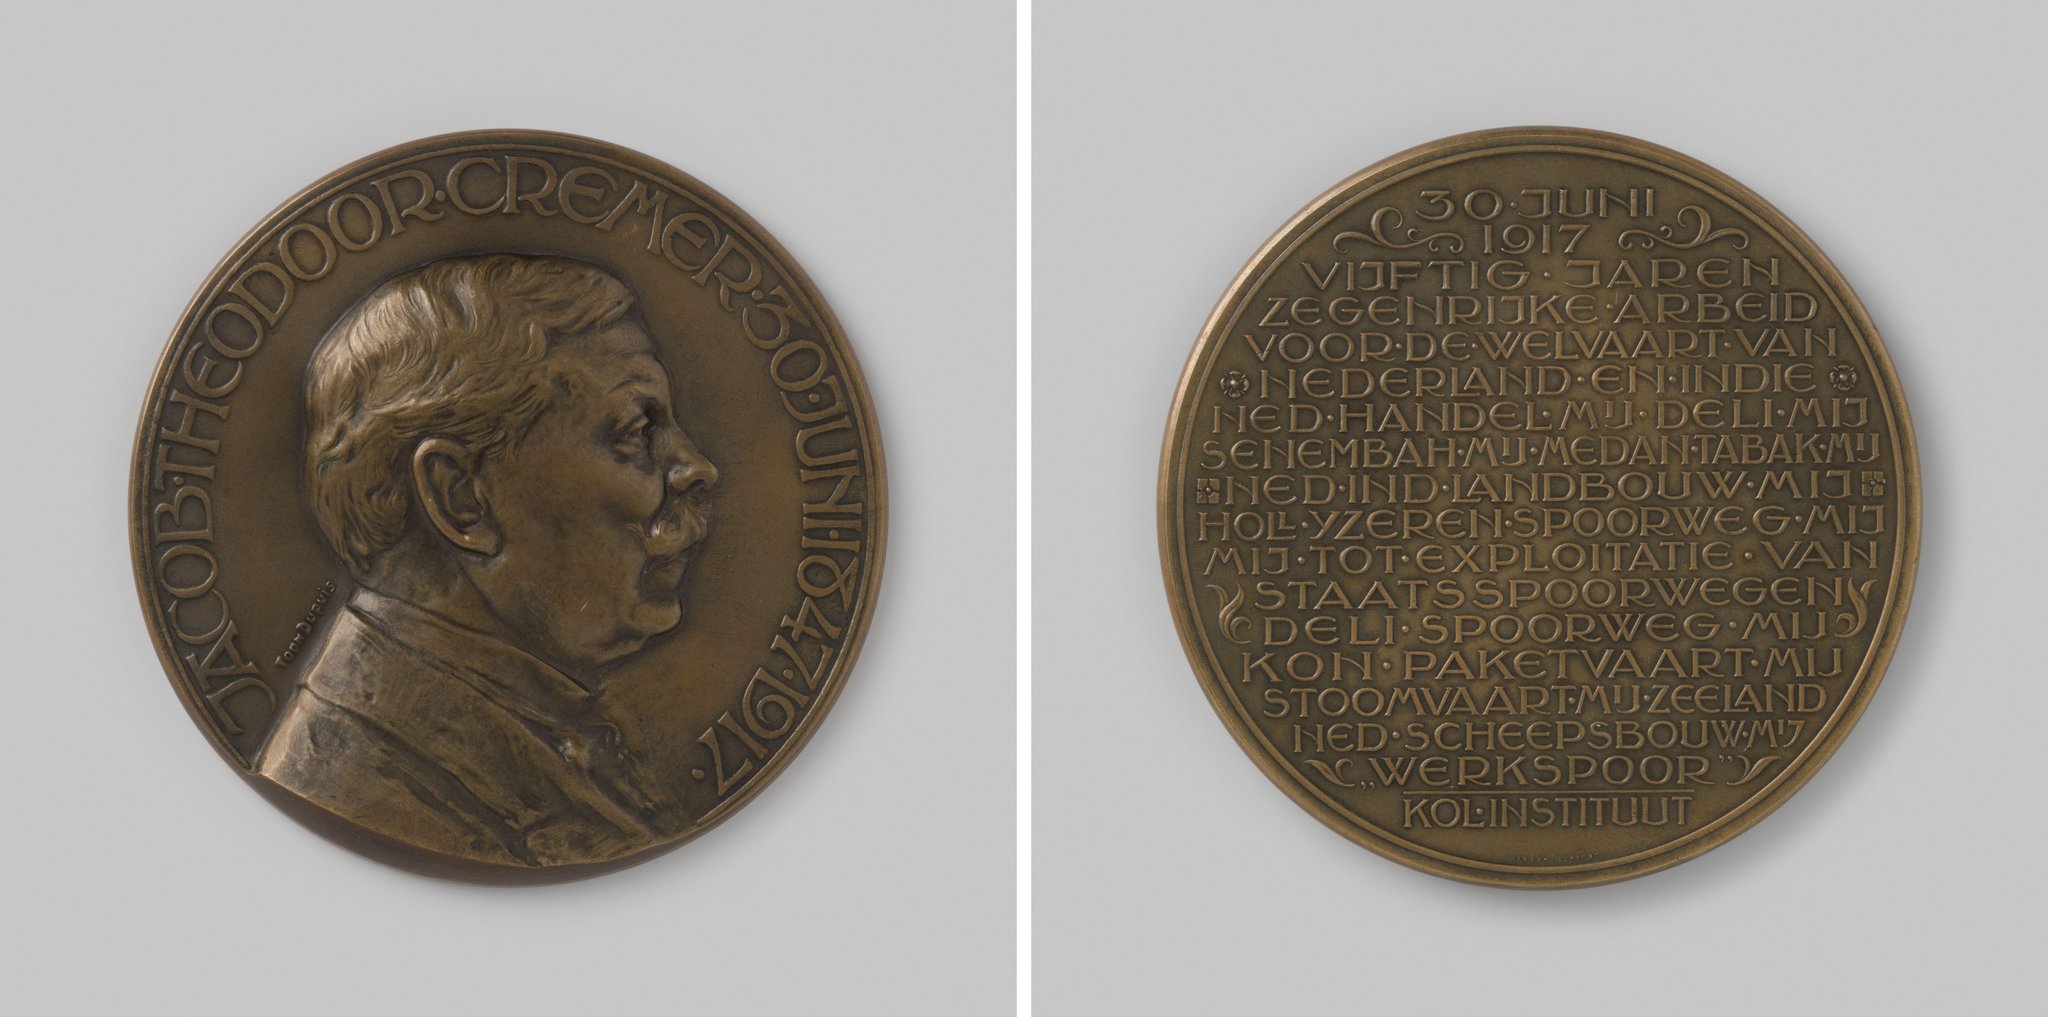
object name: medal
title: Jacob Theodoor Cremer, 70 jaar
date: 1917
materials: bronze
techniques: striking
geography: utrecht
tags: amsterdam, netherlands, dutch east indies, the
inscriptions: circumscription: ‘JACOB THEODOOR CREMER 30 JUNI 1847 1917’, inscription: ‘30 JUNI 1917 VIJFTIG JAREN ZEGENRIJKE ARBEID VOOR DE WELVAART VAN NEDERLAND EN INDIE NED HANDEL MIJ DELI MIJ SENEMBAH MIJ MEDAN TABAK MIJ NED IND LANDBOUW MIJ HOLL IJZEREN SPOORWEG MIJ MIJ TOT EXPLOITATIE VAN STAATSSPOORWEGEN DELI SPOORWEG MIJ KON PAKETVAART MIJ STOOMVAART MIJ ZEELAND NED SCHEEPSBOUW MIJ WERKSPOOR KOL INSTITUUT’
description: Bronzen penning. Voorzijde: borstbeeld van man en profil naar rechts met snor (Jacob Theodoor Cremer), met omschrift. Keerzijde: tekst binnen rand, opsomming van firma's waar Cremer actief is geweest, waaronder de Deli Mij., Senembah Mij., Medan Tabak Mij., Deli Spoorweg Mij., enz.